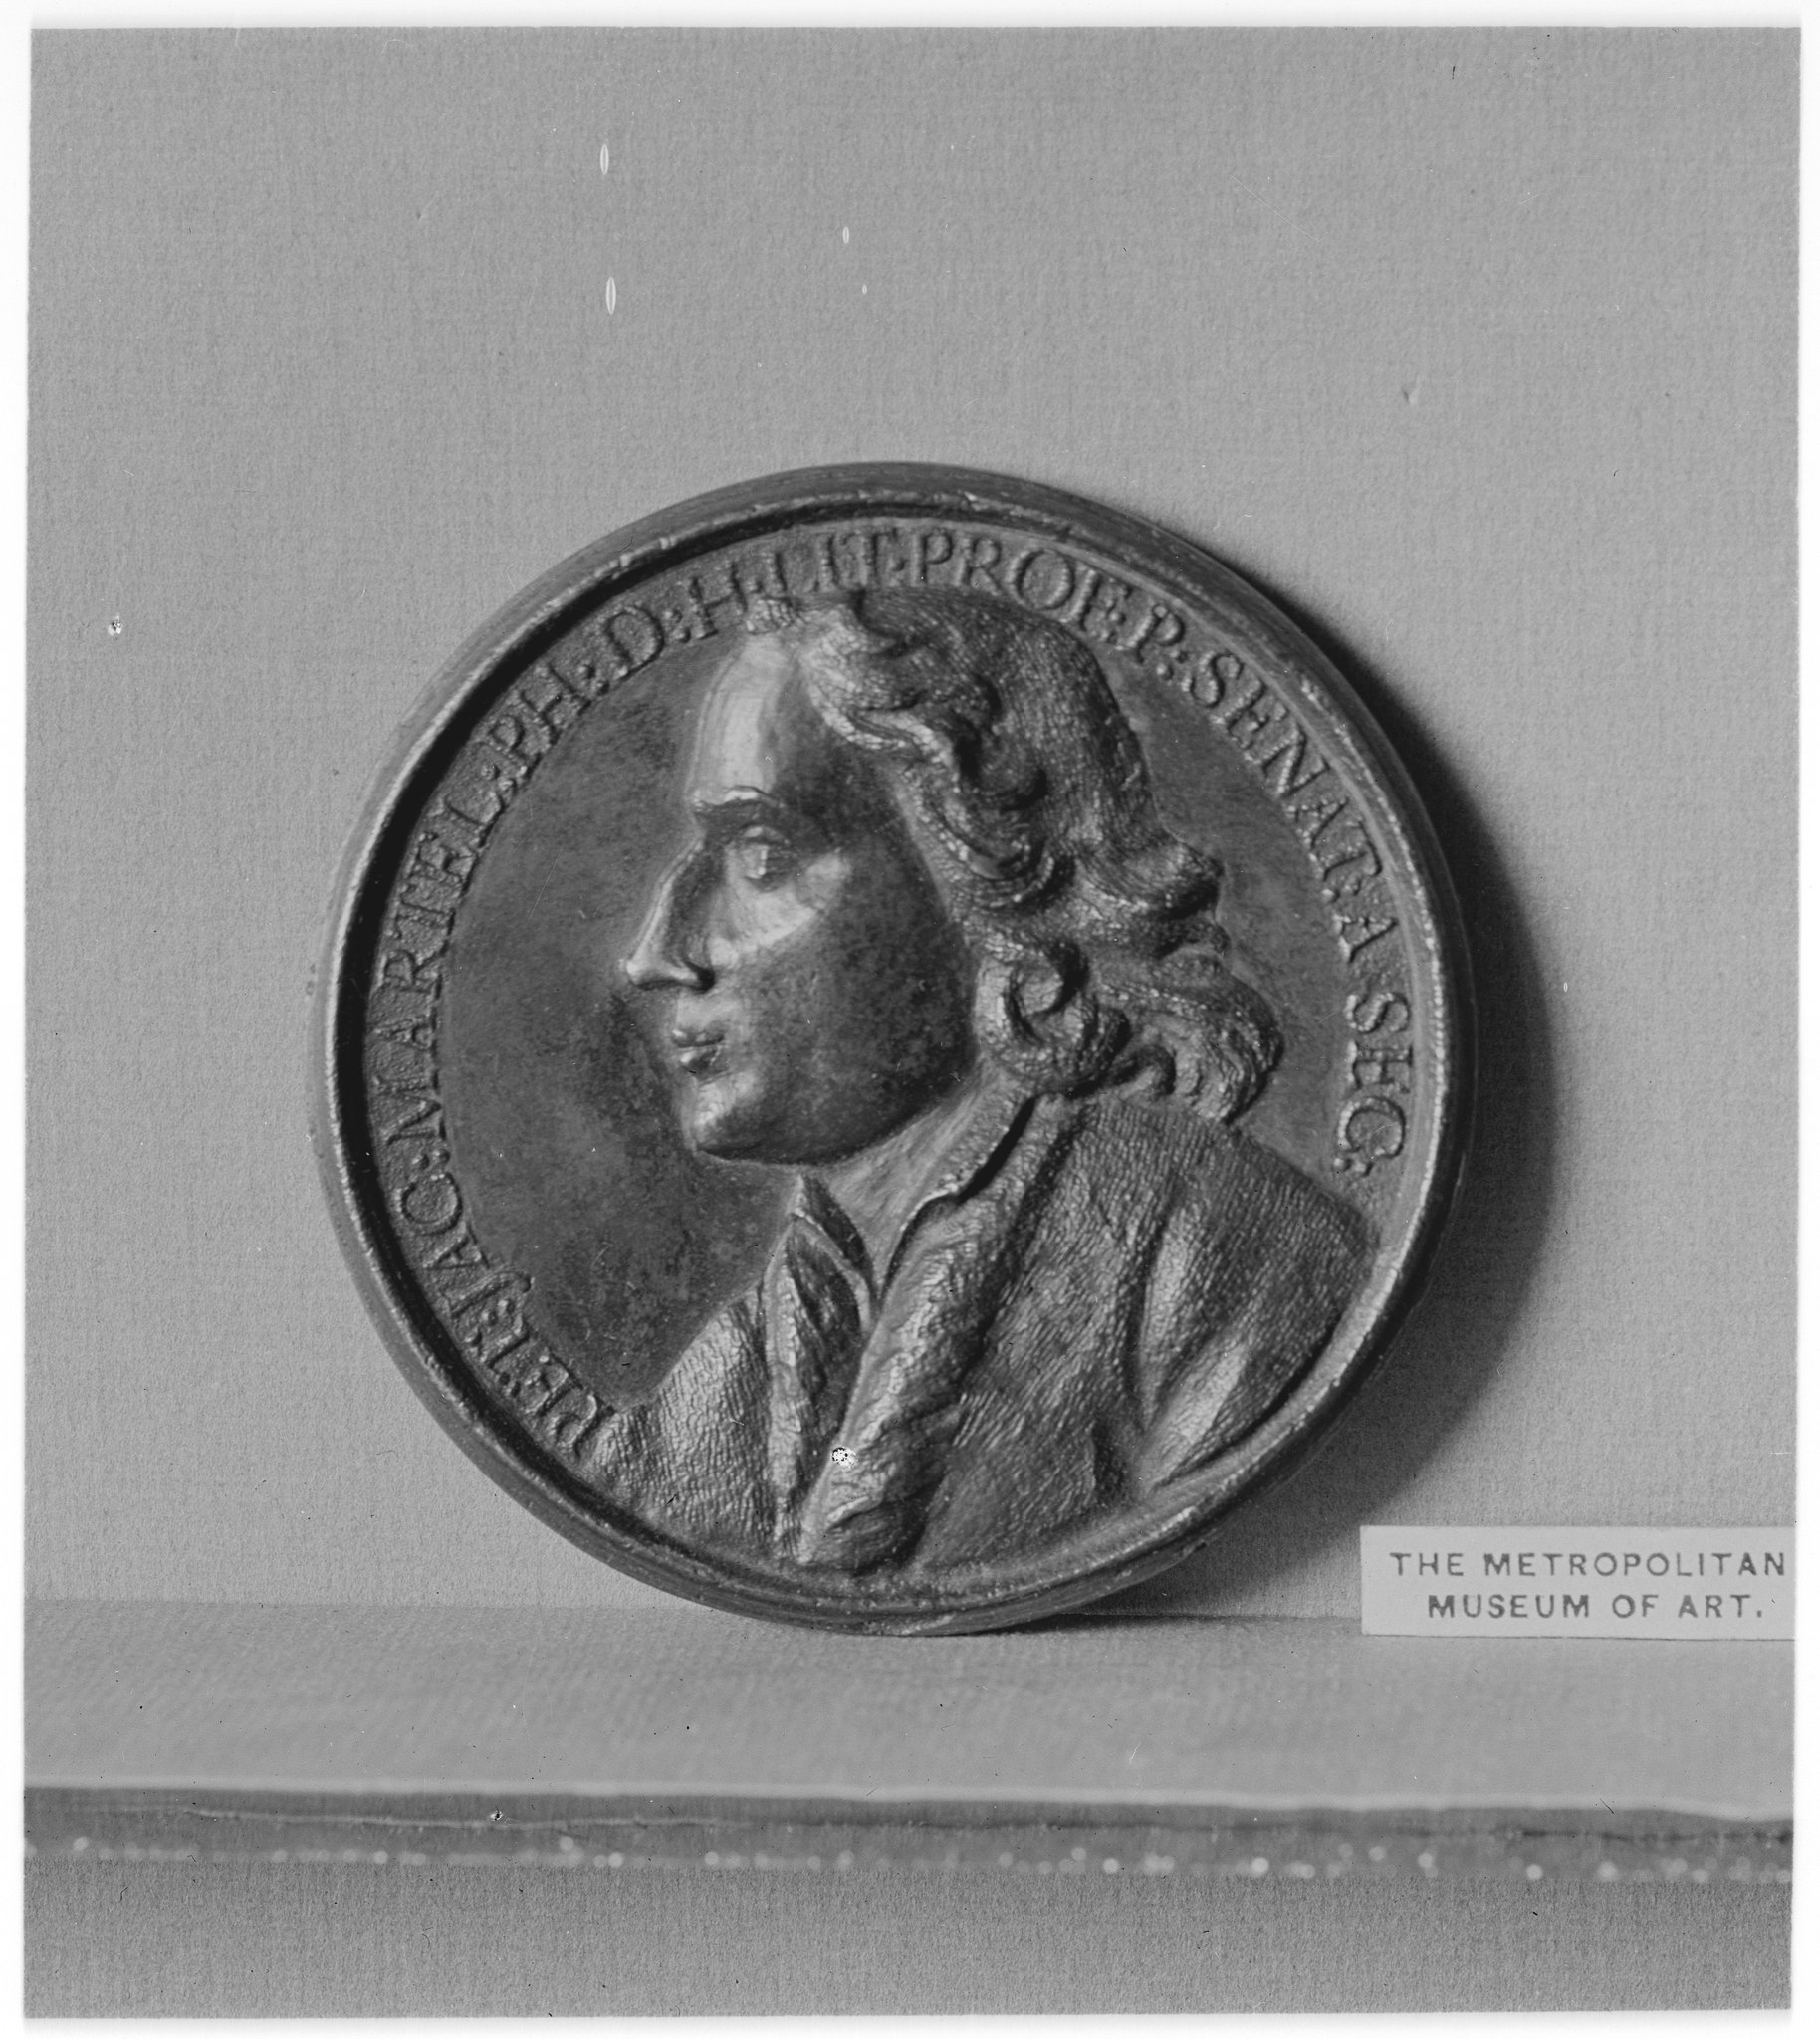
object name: medal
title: Peter James Martel, Professor of the Humanities, Doctor of Philosophy, Chief Secretary of the Senate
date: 1701-1800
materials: bronze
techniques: struck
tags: men,profiles